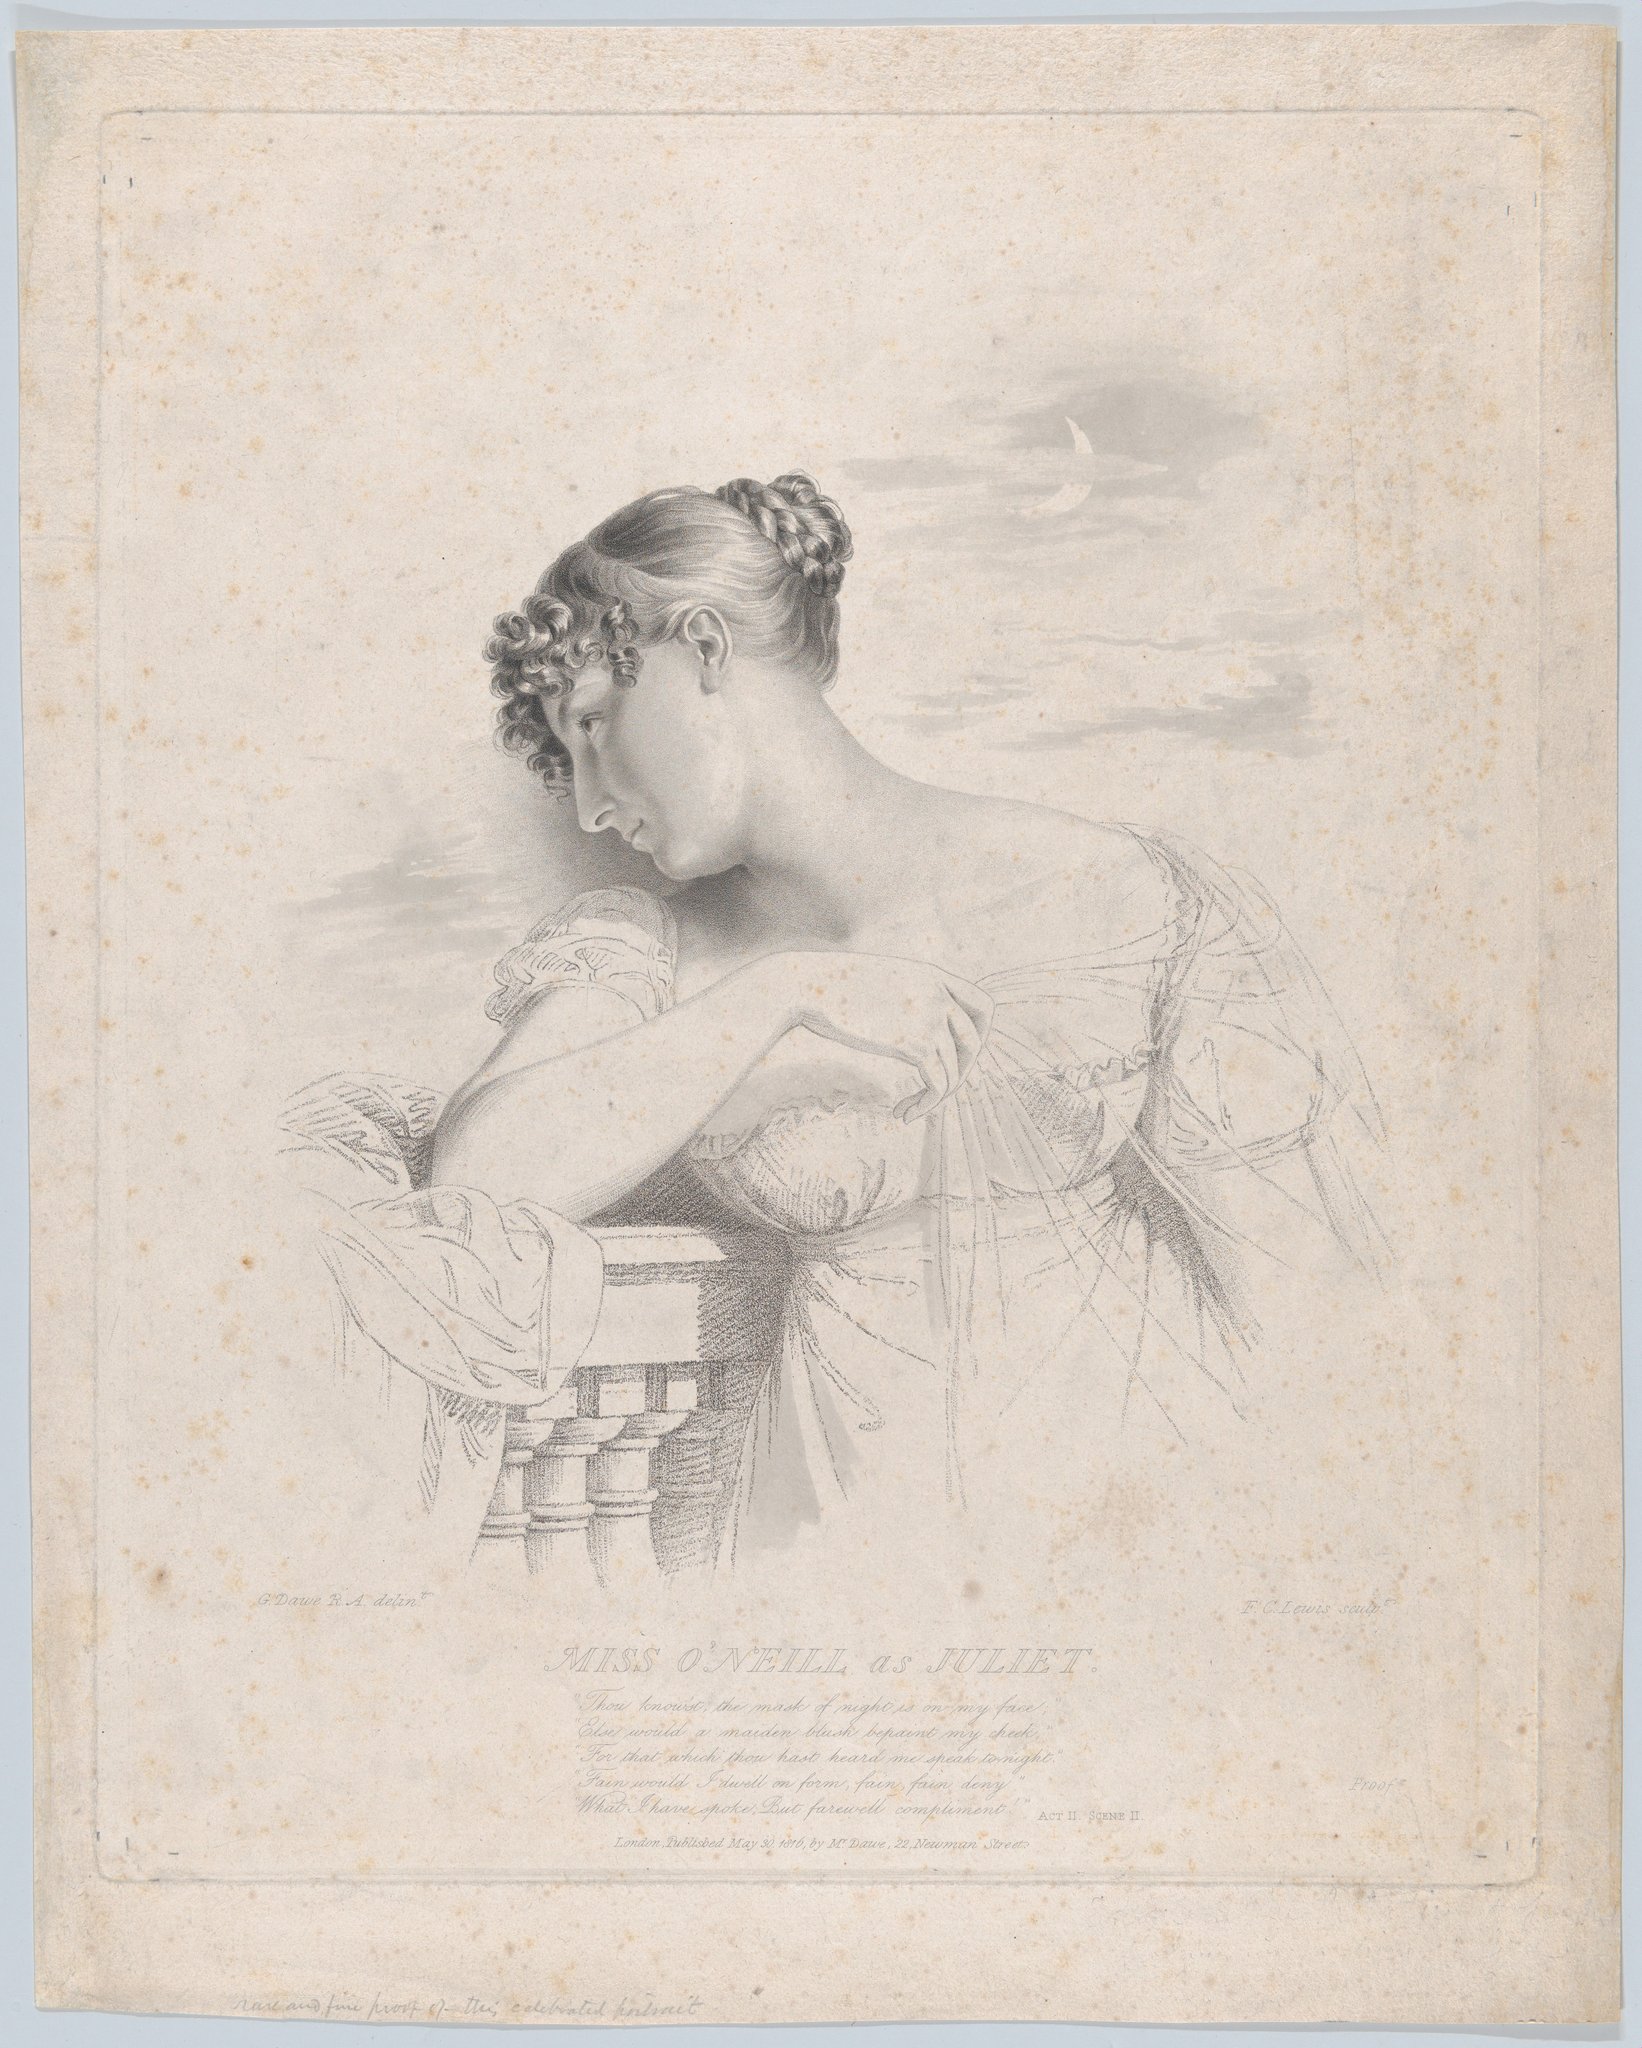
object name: print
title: Miss O'Neill as Juliet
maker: george dawe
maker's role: artist and publisher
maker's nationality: british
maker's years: 1781-1829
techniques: etching, engraving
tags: shakespeare,women,actresses